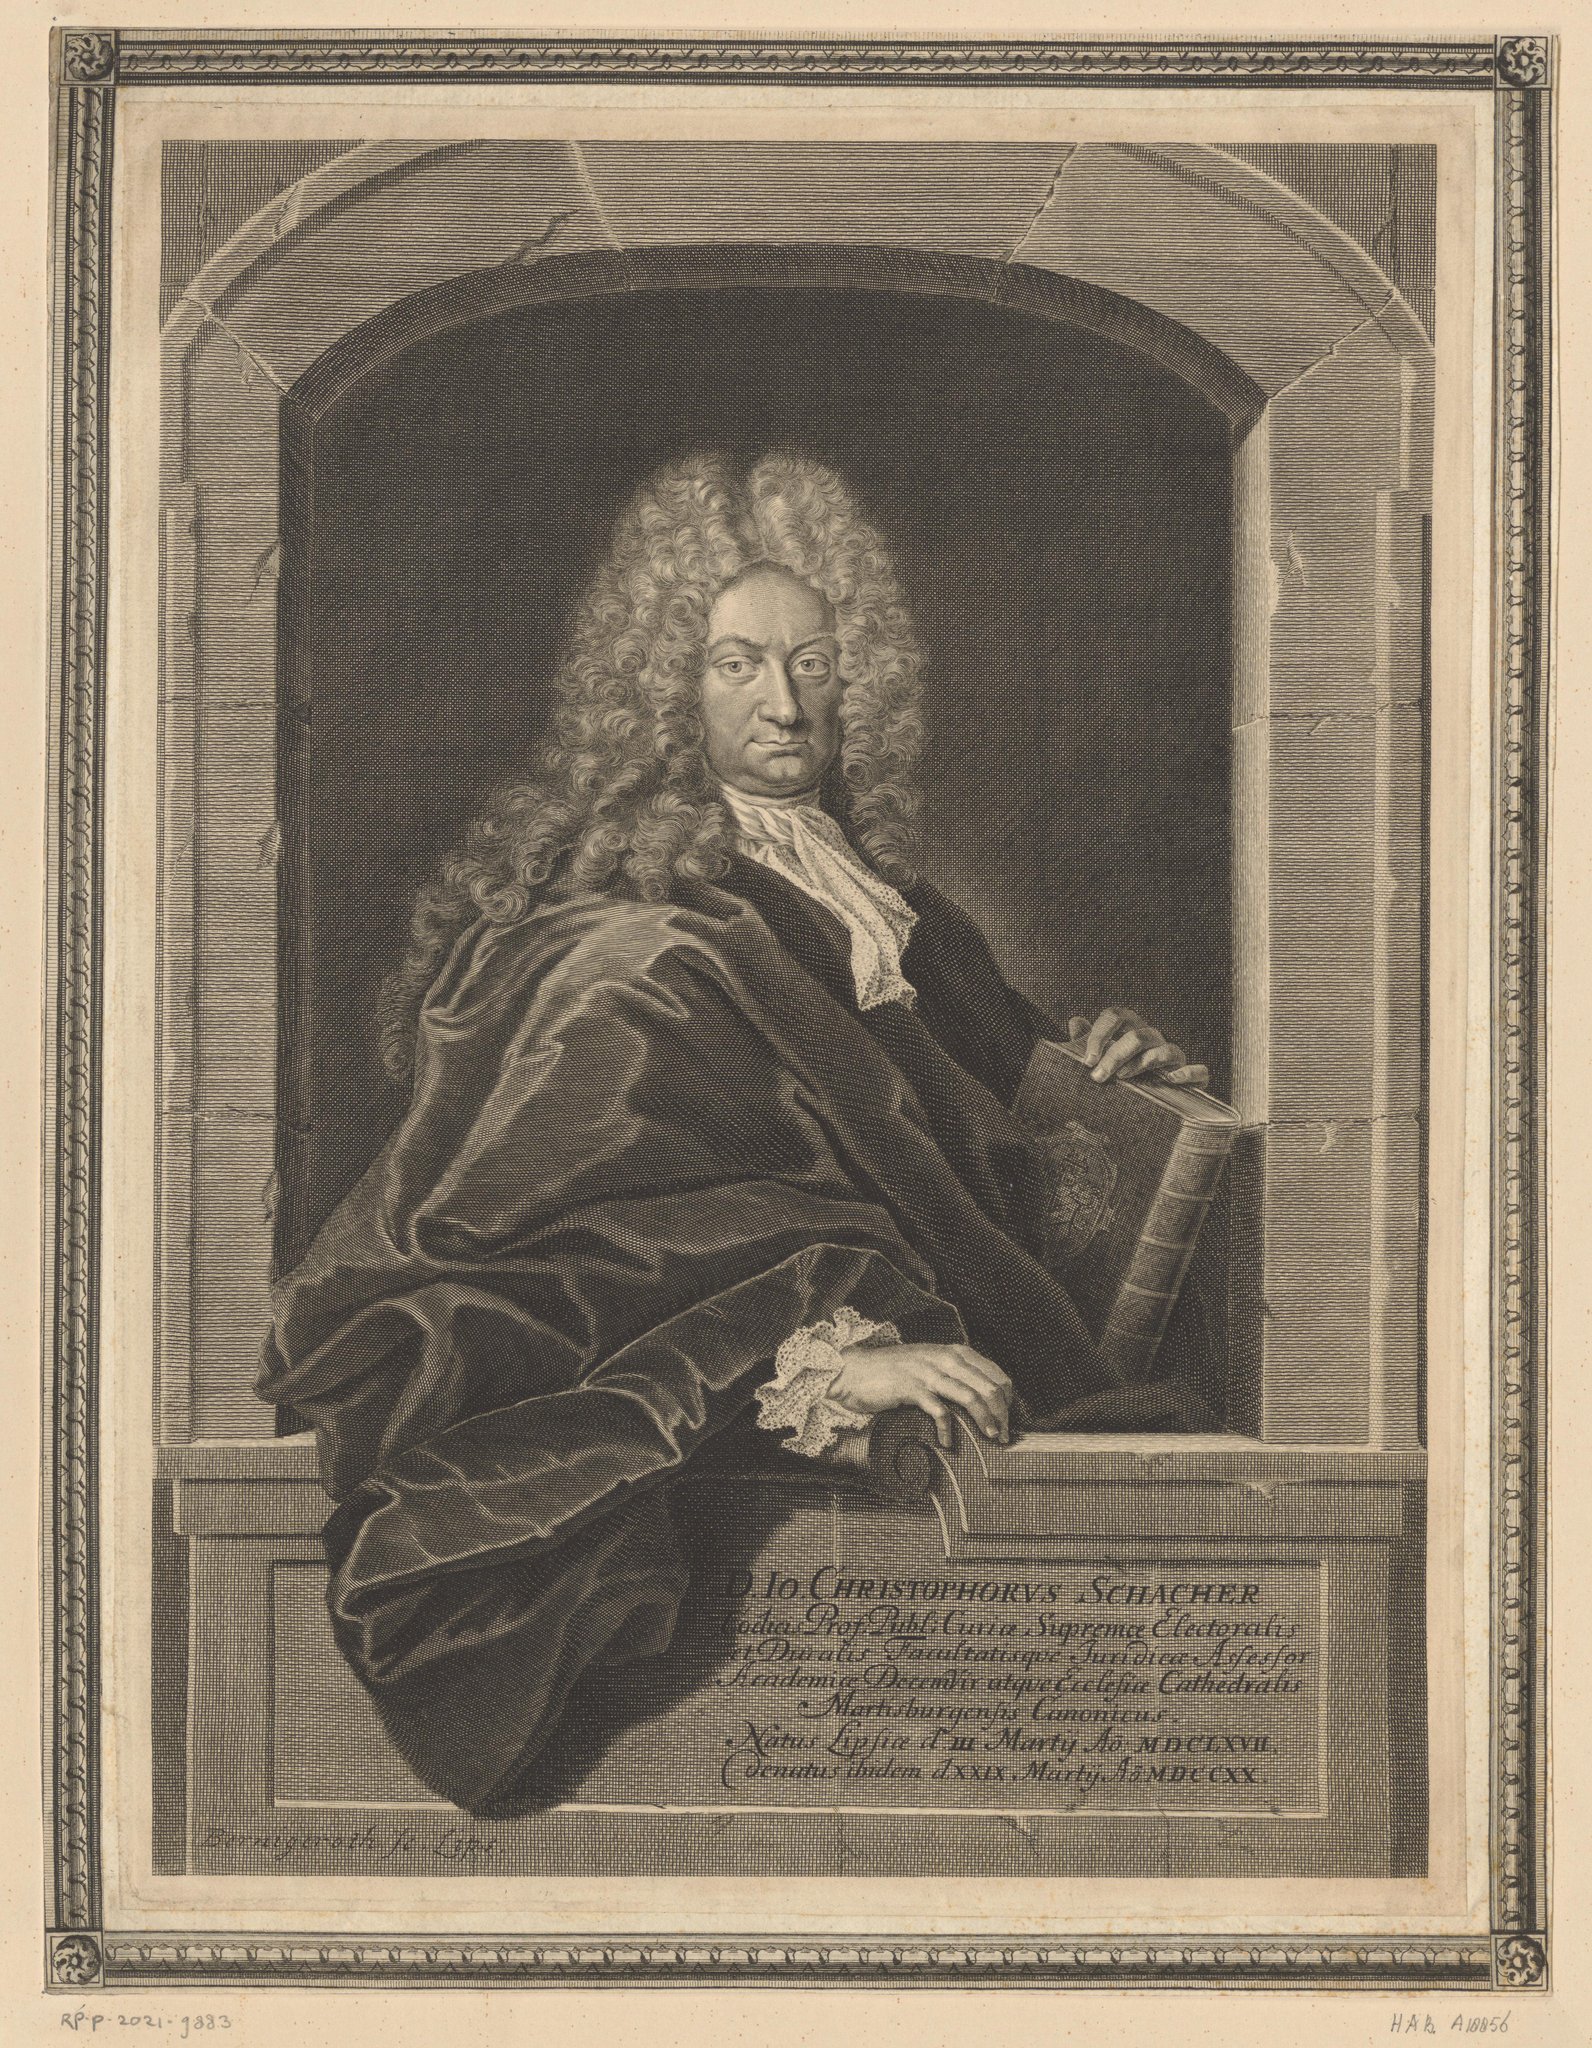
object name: print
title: Portret van Johann Christoph Schacher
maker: martin bernigeroth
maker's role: print maker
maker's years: 1670-1733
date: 1720-1733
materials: paper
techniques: engraving, etching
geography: leipzig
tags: historical persons, book